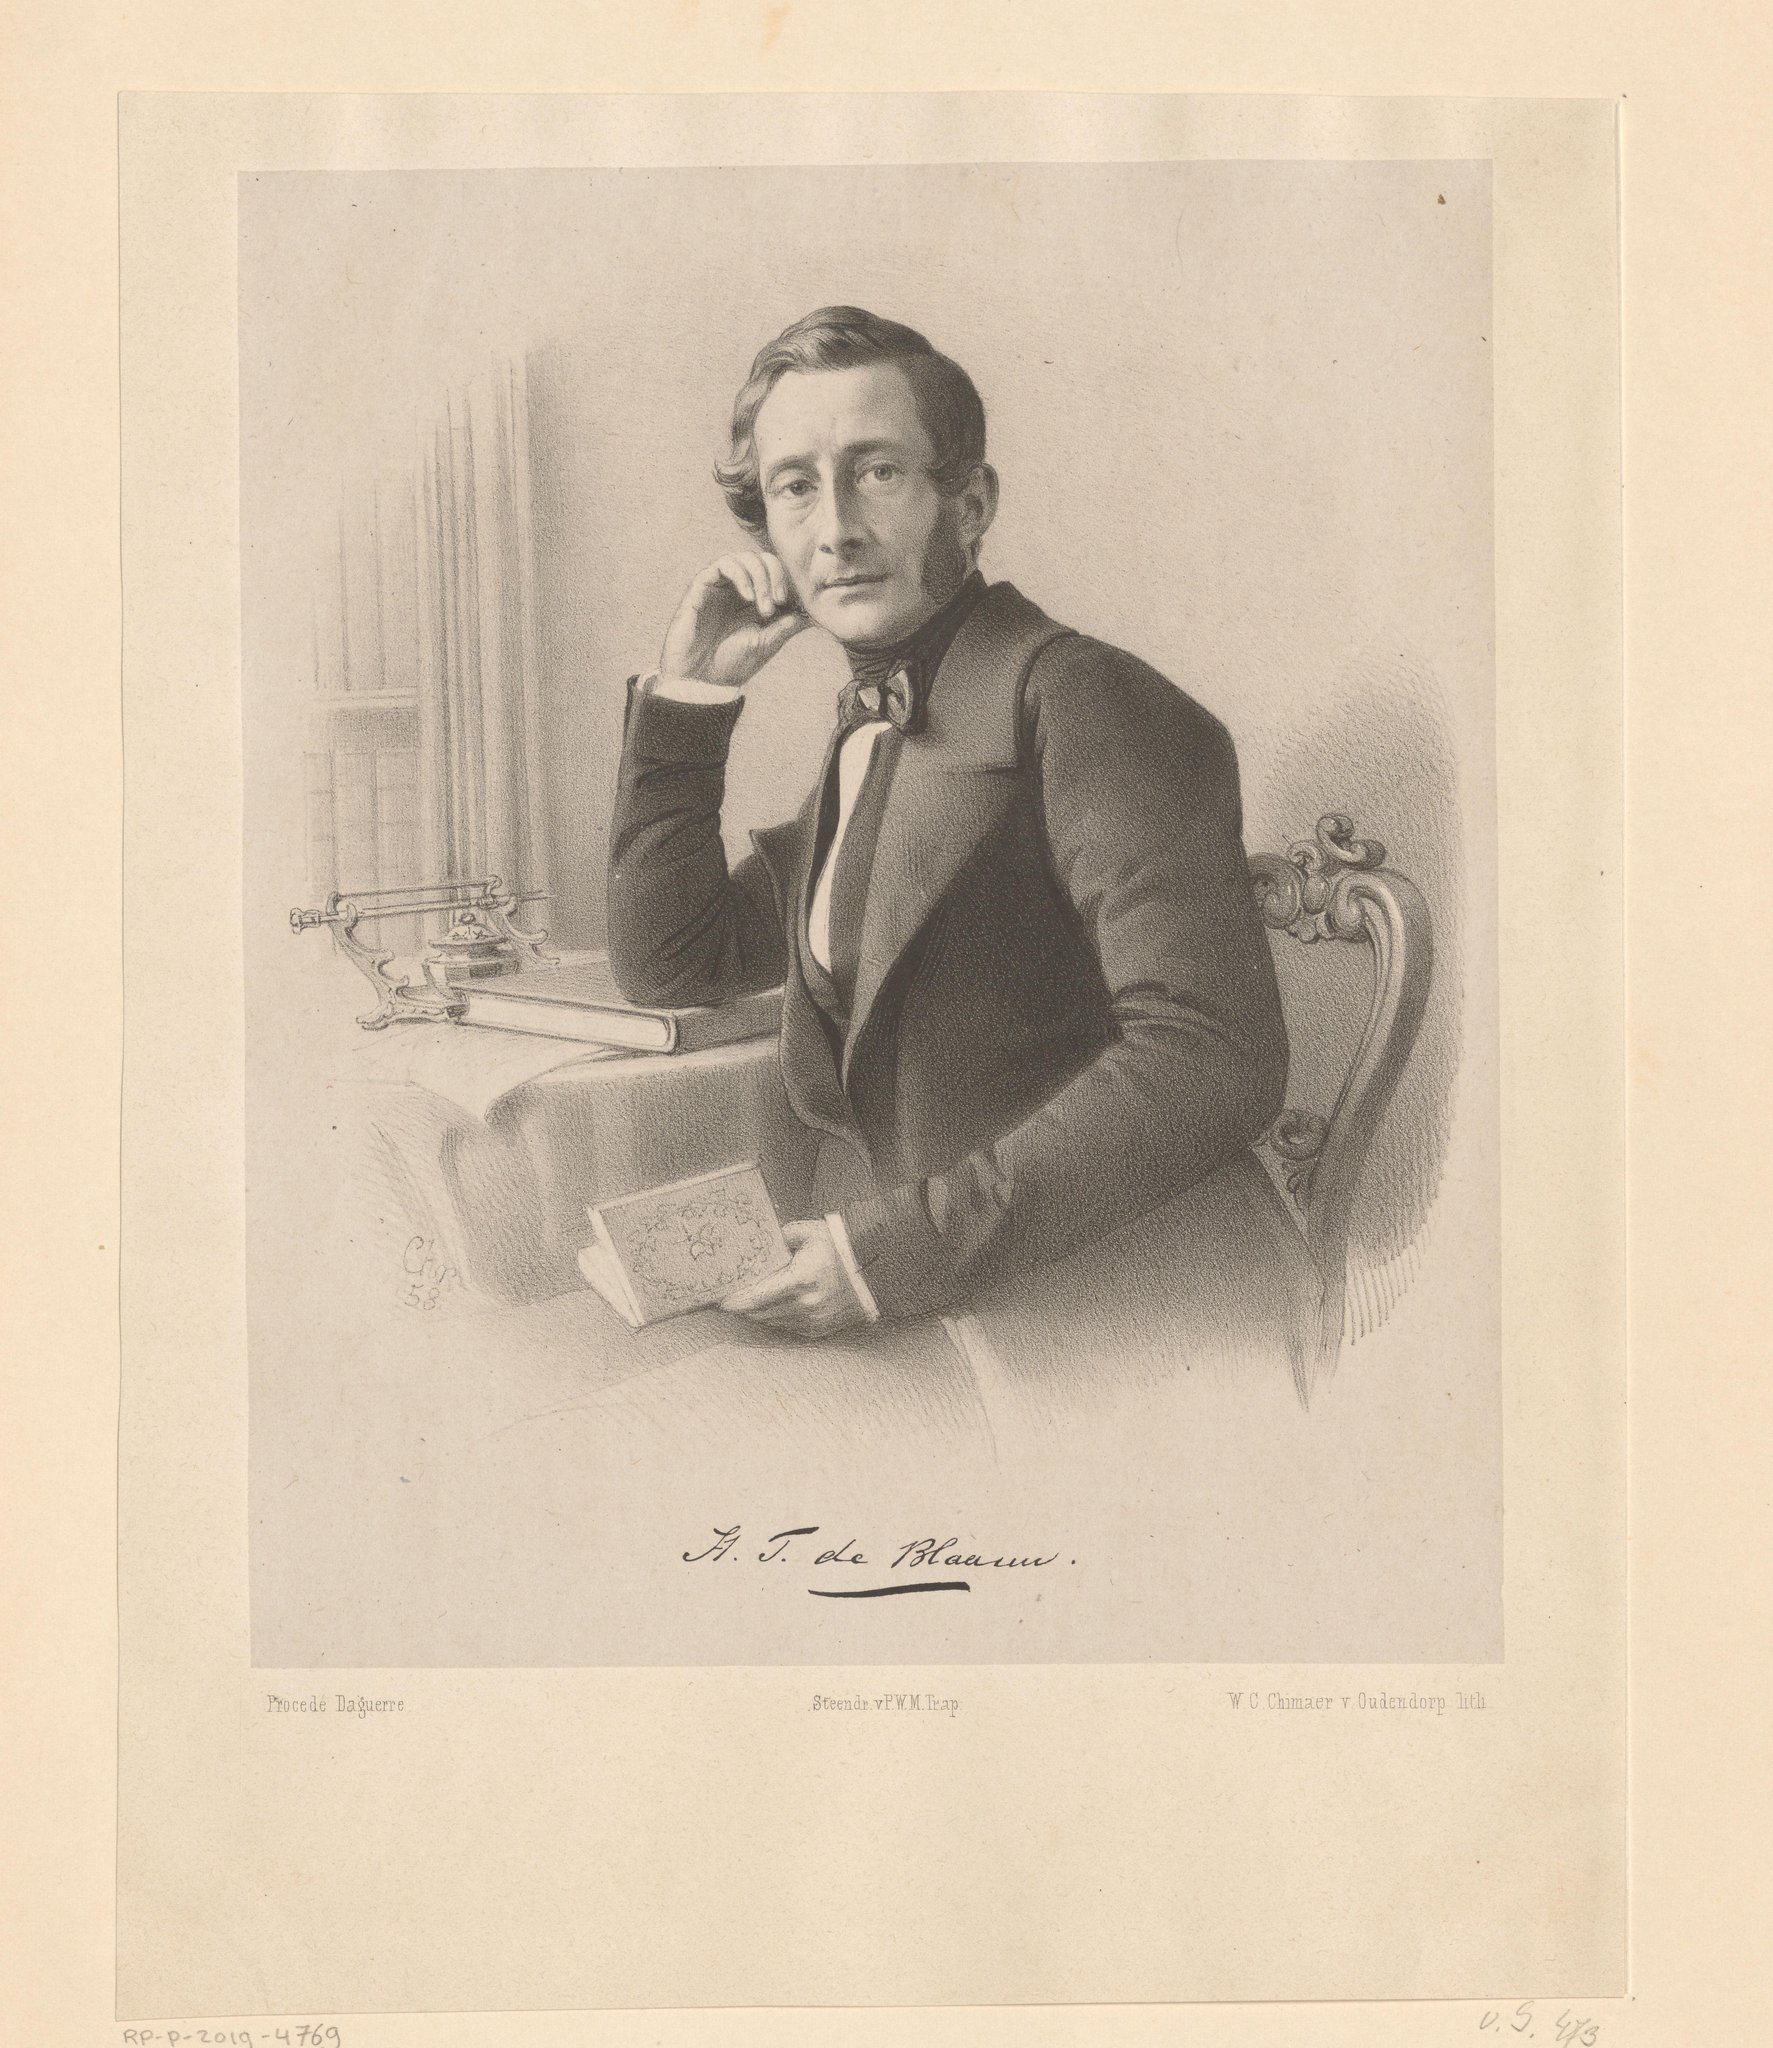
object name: print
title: Portret van Henri Thierry de Blaauw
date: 1858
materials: paper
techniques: lithograph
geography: leiden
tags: bookshelves, historical persons, book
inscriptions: date